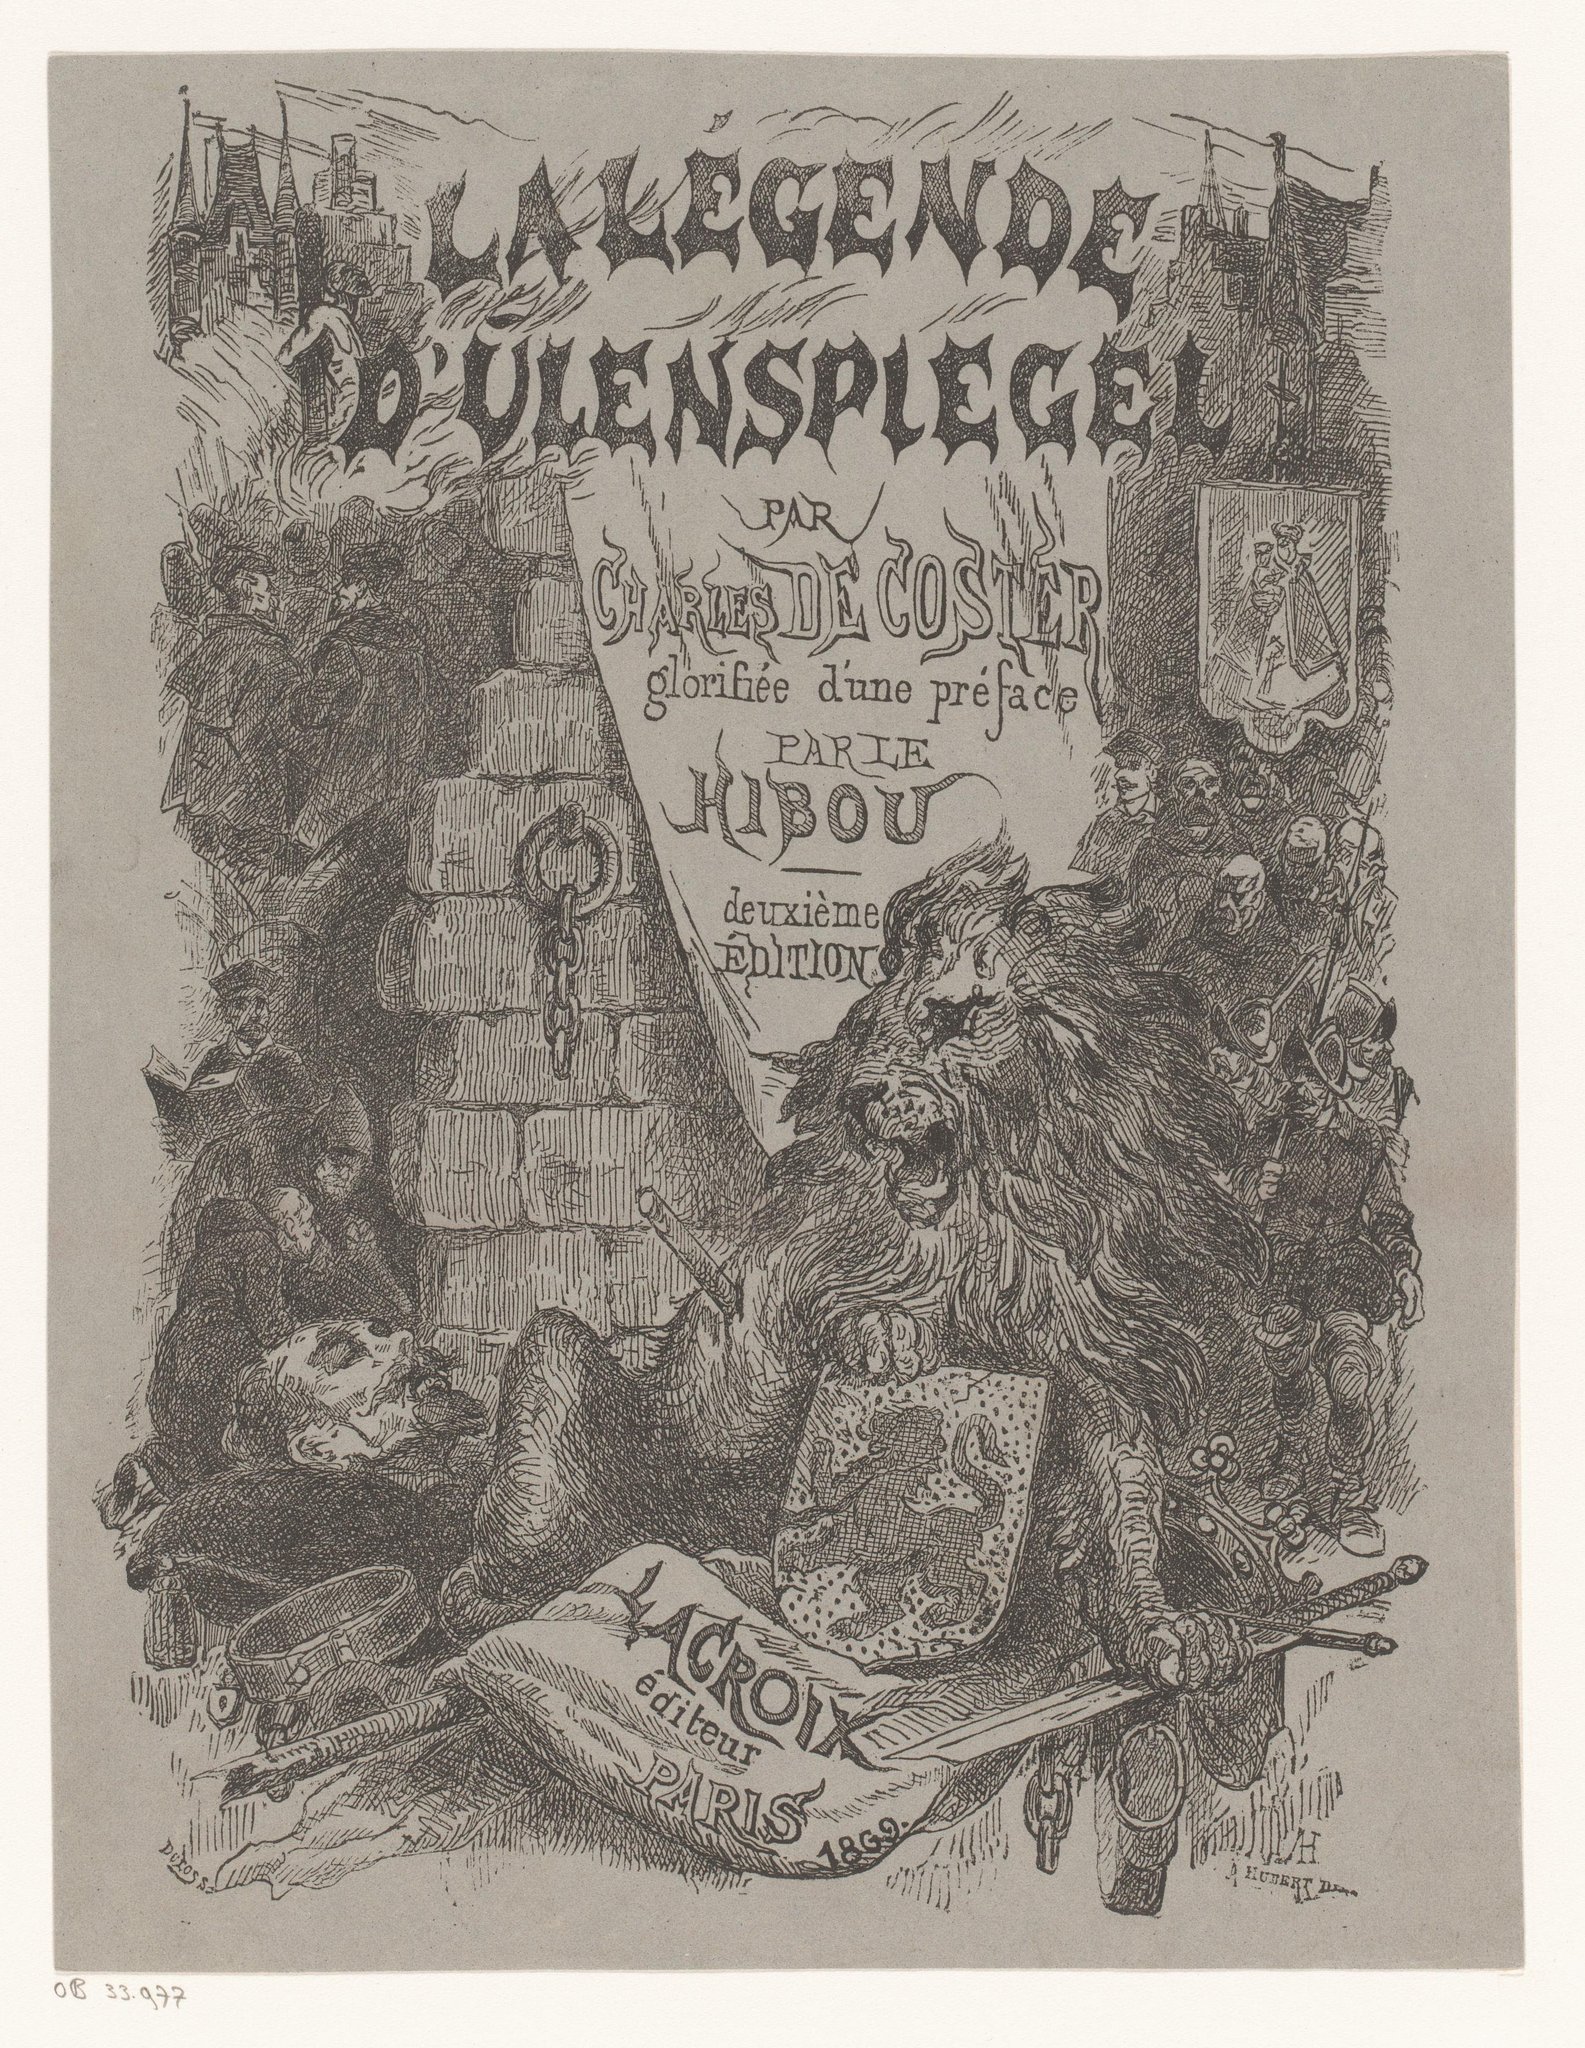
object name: titelblad, titelpagina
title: La Légende d'Ulenspiegel par Charles de Coster glorifiée d'une préface parle Hibou, deuxième édition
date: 1869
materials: paper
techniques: engraving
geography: paris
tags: head (human), hacking and thrusting weapons: sword, eulenspiegel, city-walls, beasts of prey, predatory animals: lion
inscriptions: collector's mark: Lugt 2228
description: Titelpagina voor: Charles de Coster. La légende et les aventures héroiques, joyeuses et glorieuses d'Ulenspiegel et de Lamme Goedzak au pays de Flandres et ailleurs. Brussel: A. Lacroix, 1869.